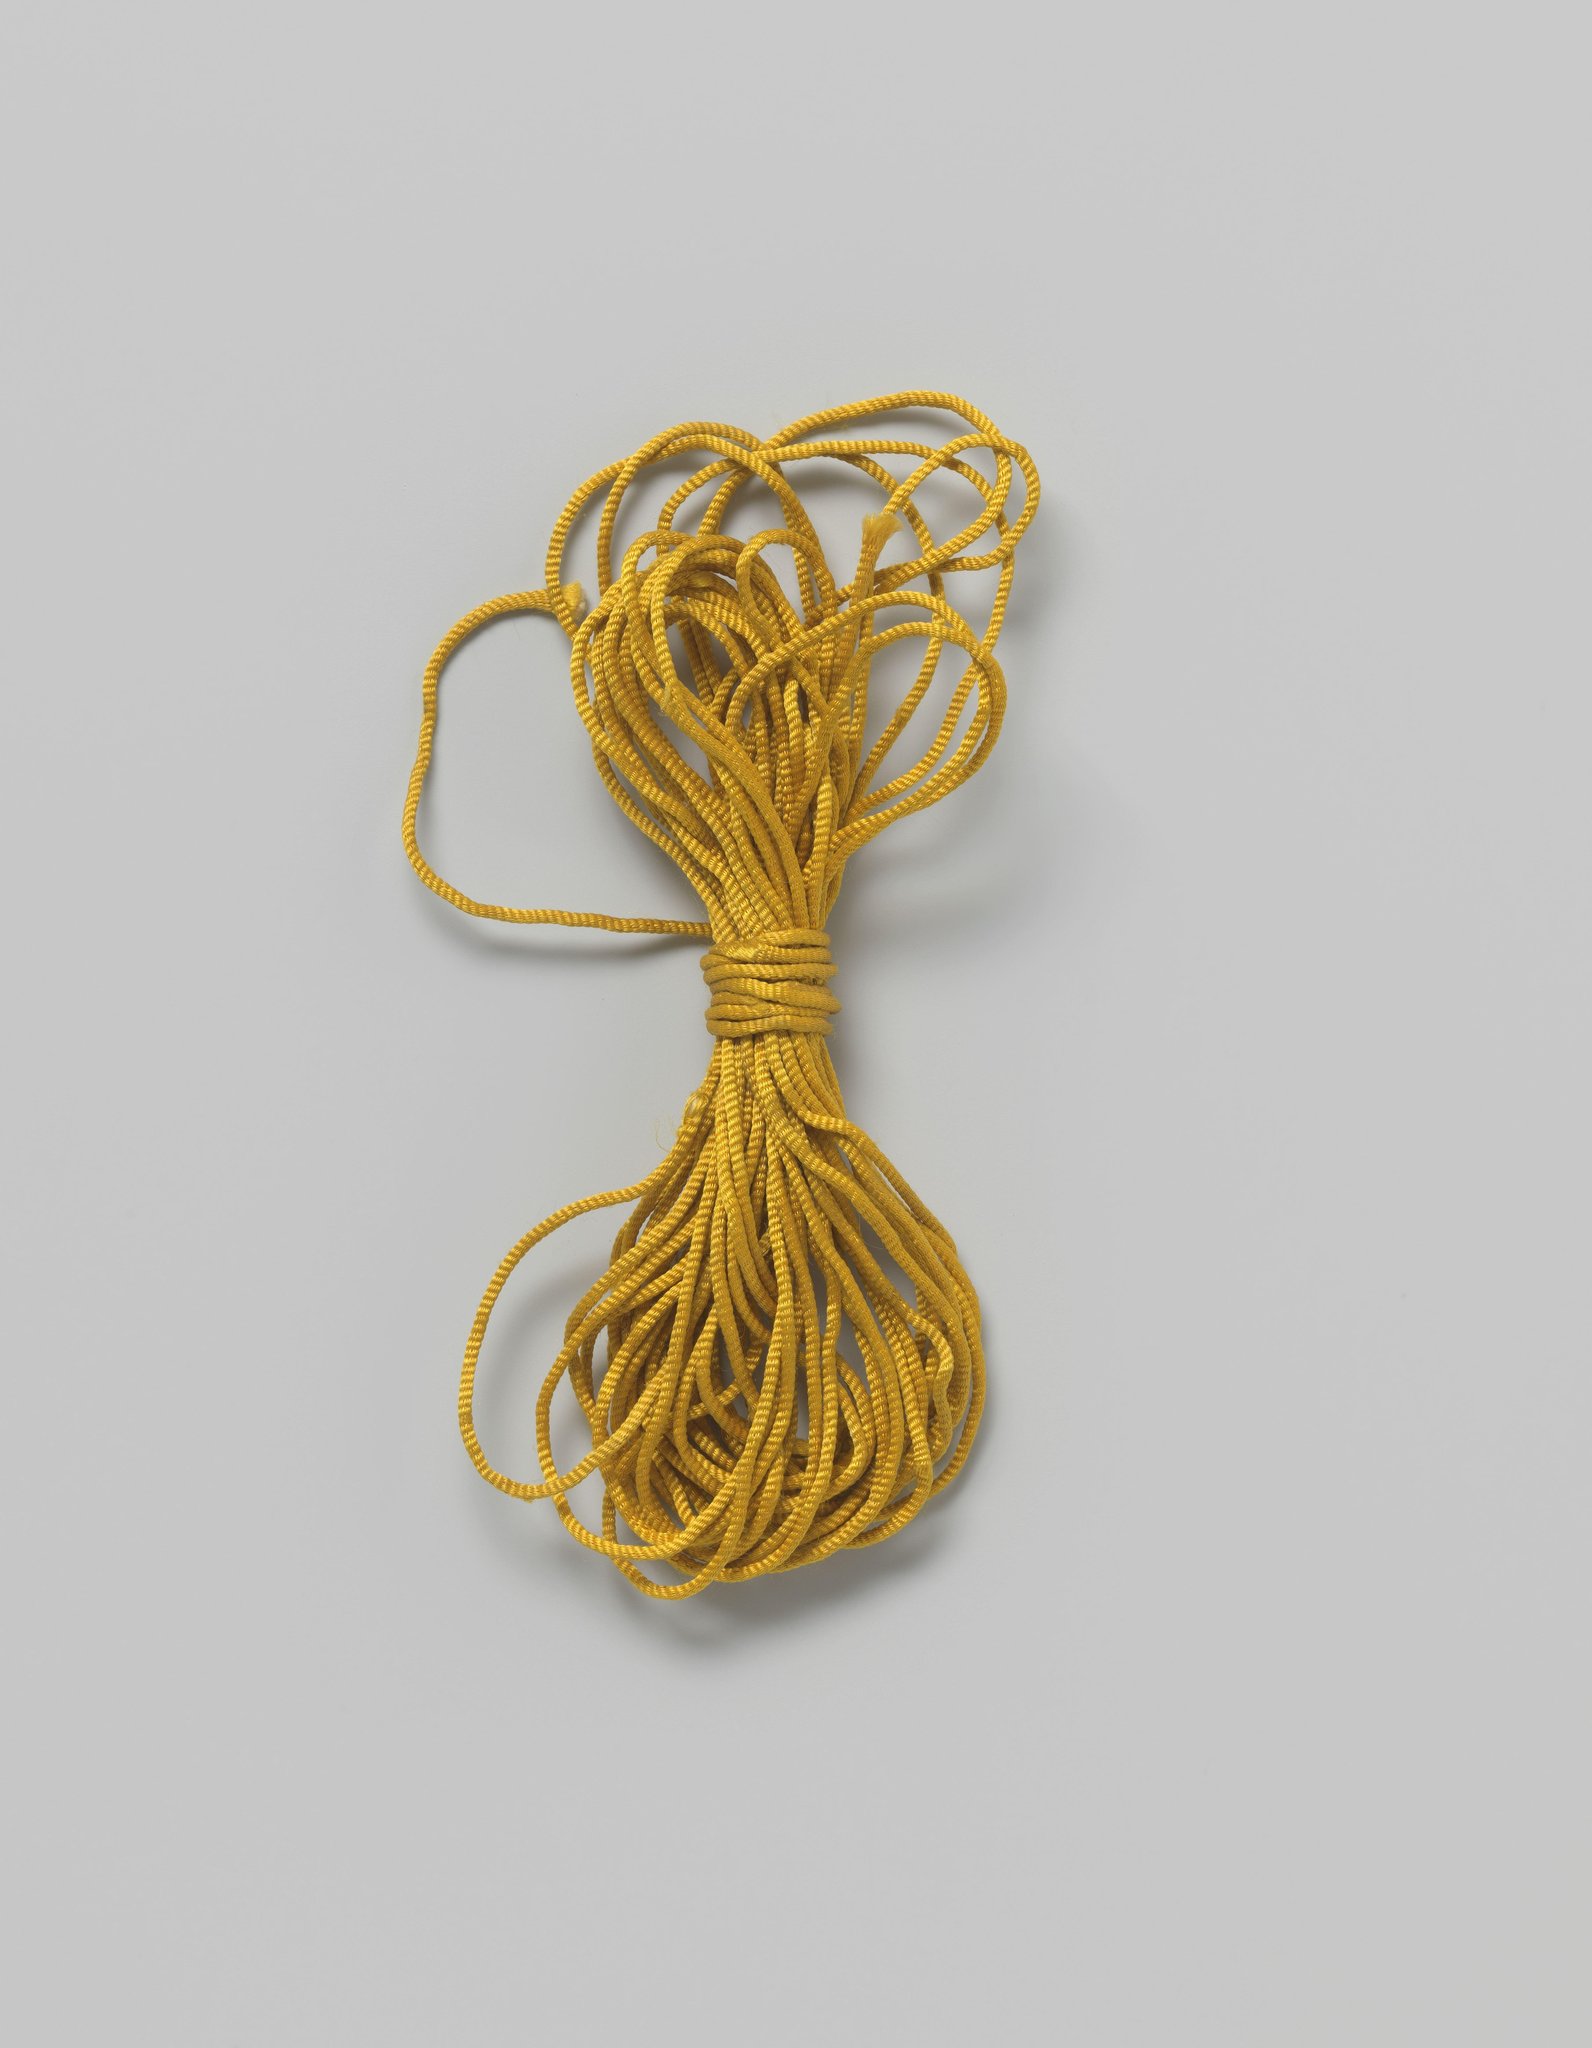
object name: kledingfragment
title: Metrage van geel zijdekoord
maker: Anonymous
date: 1800-1825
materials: silk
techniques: weave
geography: netherlands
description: Metrage van geel zijdekoord, samen met drie metrages lichtblauw zijdekoord met knopspelden op handgeschept papier gezet. Dit koord werd op de staande voornaden van rokvoorpanden gezet.